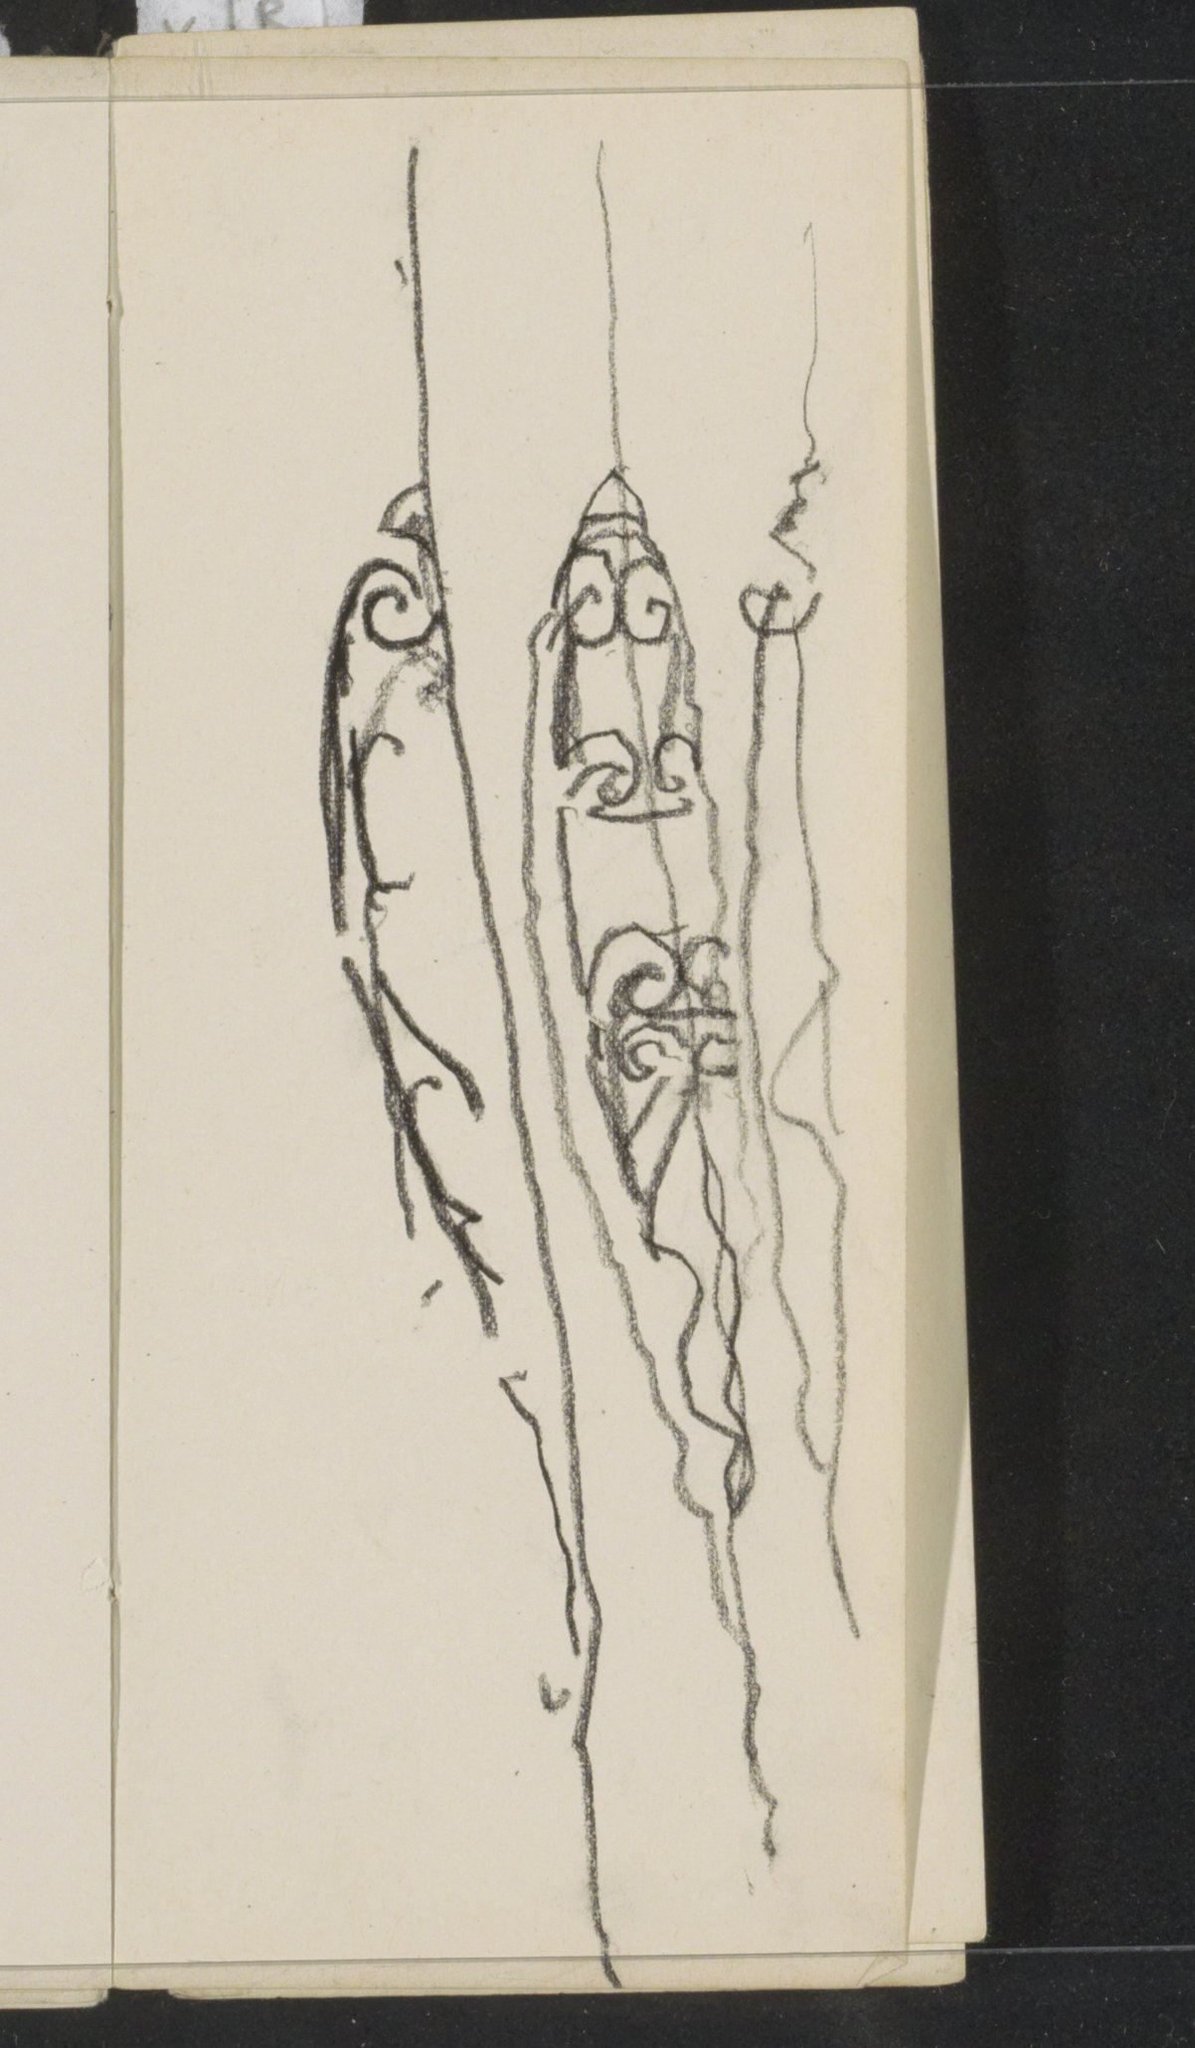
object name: sketchbook leaf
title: Ornamenten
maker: gerrit willem dijsselhof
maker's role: designer, draughtsman, print maker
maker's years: 1866-1924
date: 1901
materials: chalk, paper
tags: ornaments ~ art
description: Blad 11 recto uit een schetsboek met 42 bladzijden.